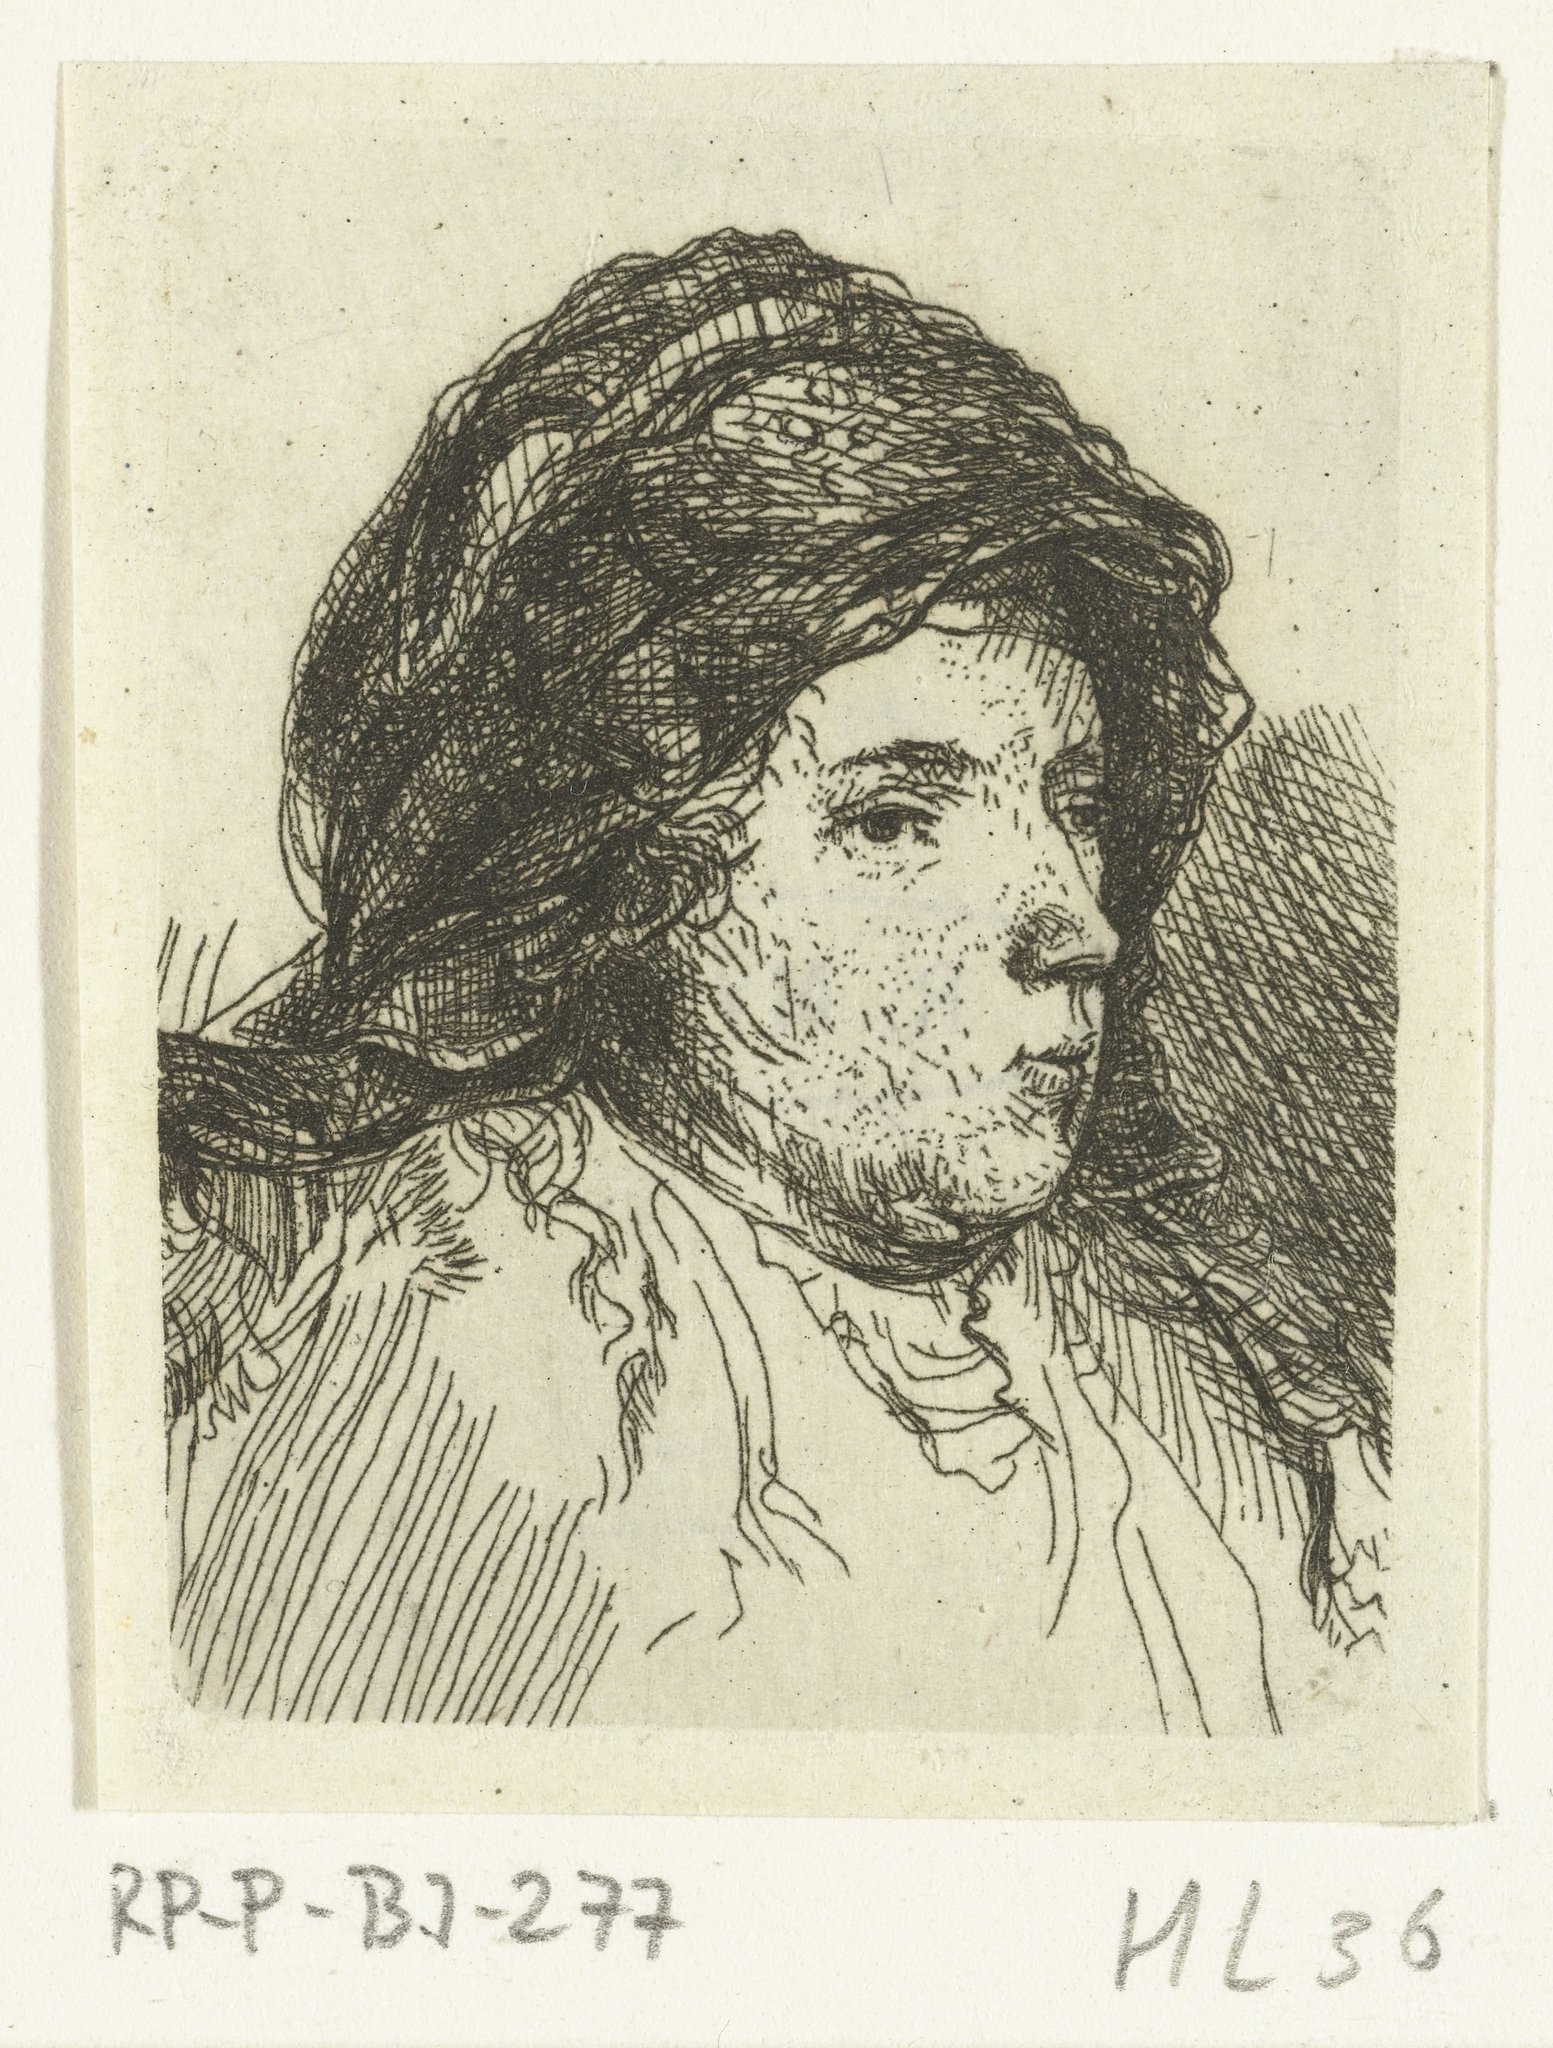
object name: print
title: Portretbuste van een vrouw met doek om haar hoofd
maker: ernst willem jan bagelaar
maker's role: draughtsman, print maker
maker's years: 1775-1837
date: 1798-1837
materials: paper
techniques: etching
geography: netherlands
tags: adolescent, young woman, maiden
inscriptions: collector's mark: Lugt 2228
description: kopie in spiegelbeeld naar Rembrandt: Bartsch 368